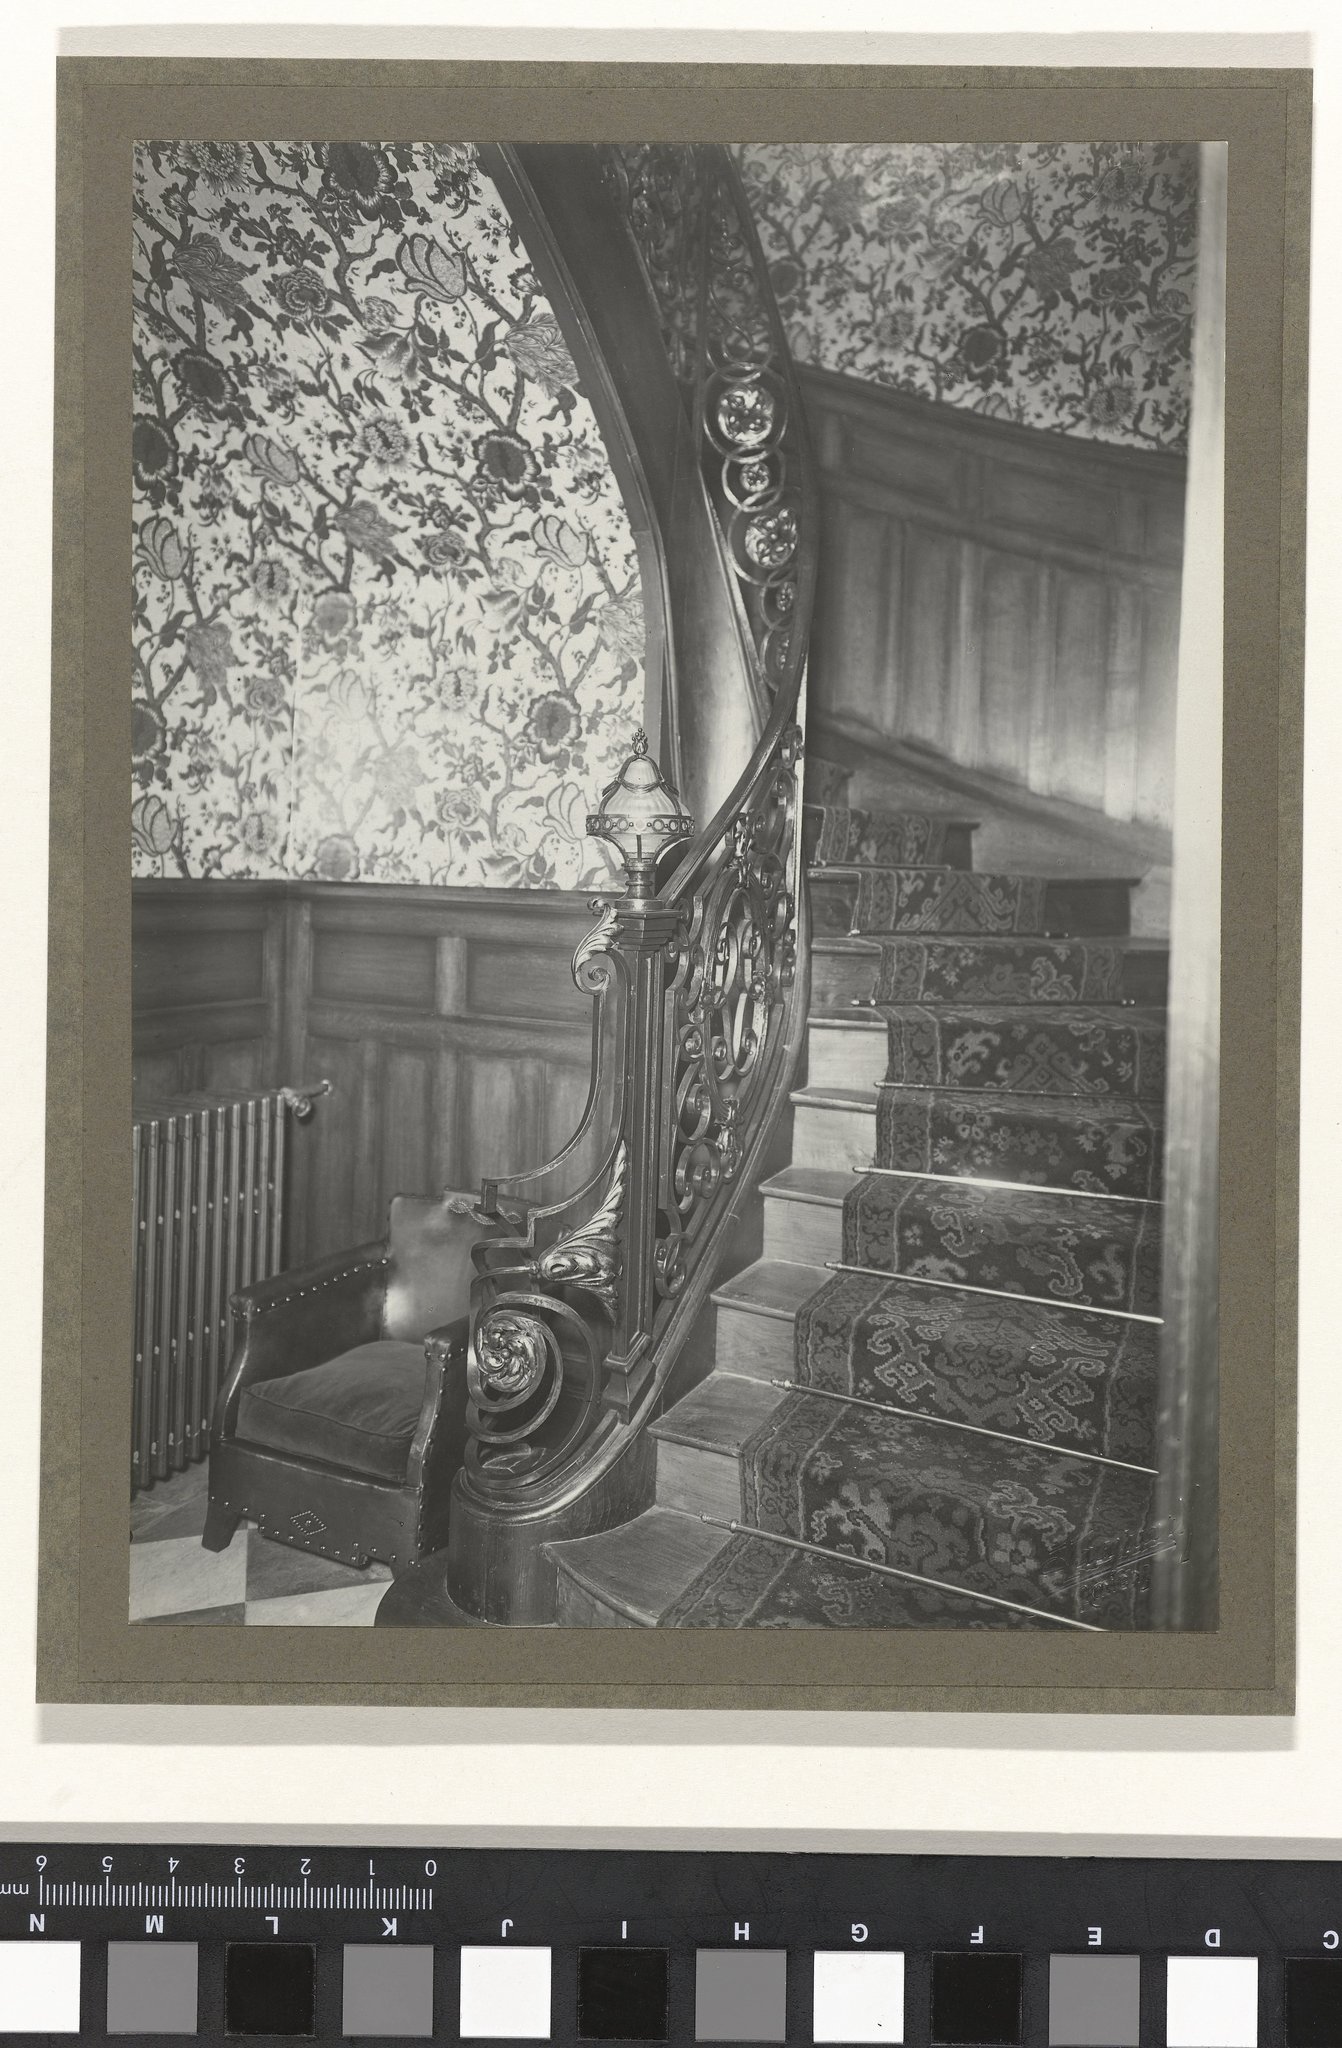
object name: photograph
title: Interieur met trap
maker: lucien hacquart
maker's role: fotograaf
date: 1900-1920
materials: paper, cardboard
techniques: gelatin silver print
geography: amiens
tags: vestibule, hall, staircase, france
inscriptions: check stamp: ‘Hacquart/ Amiens’